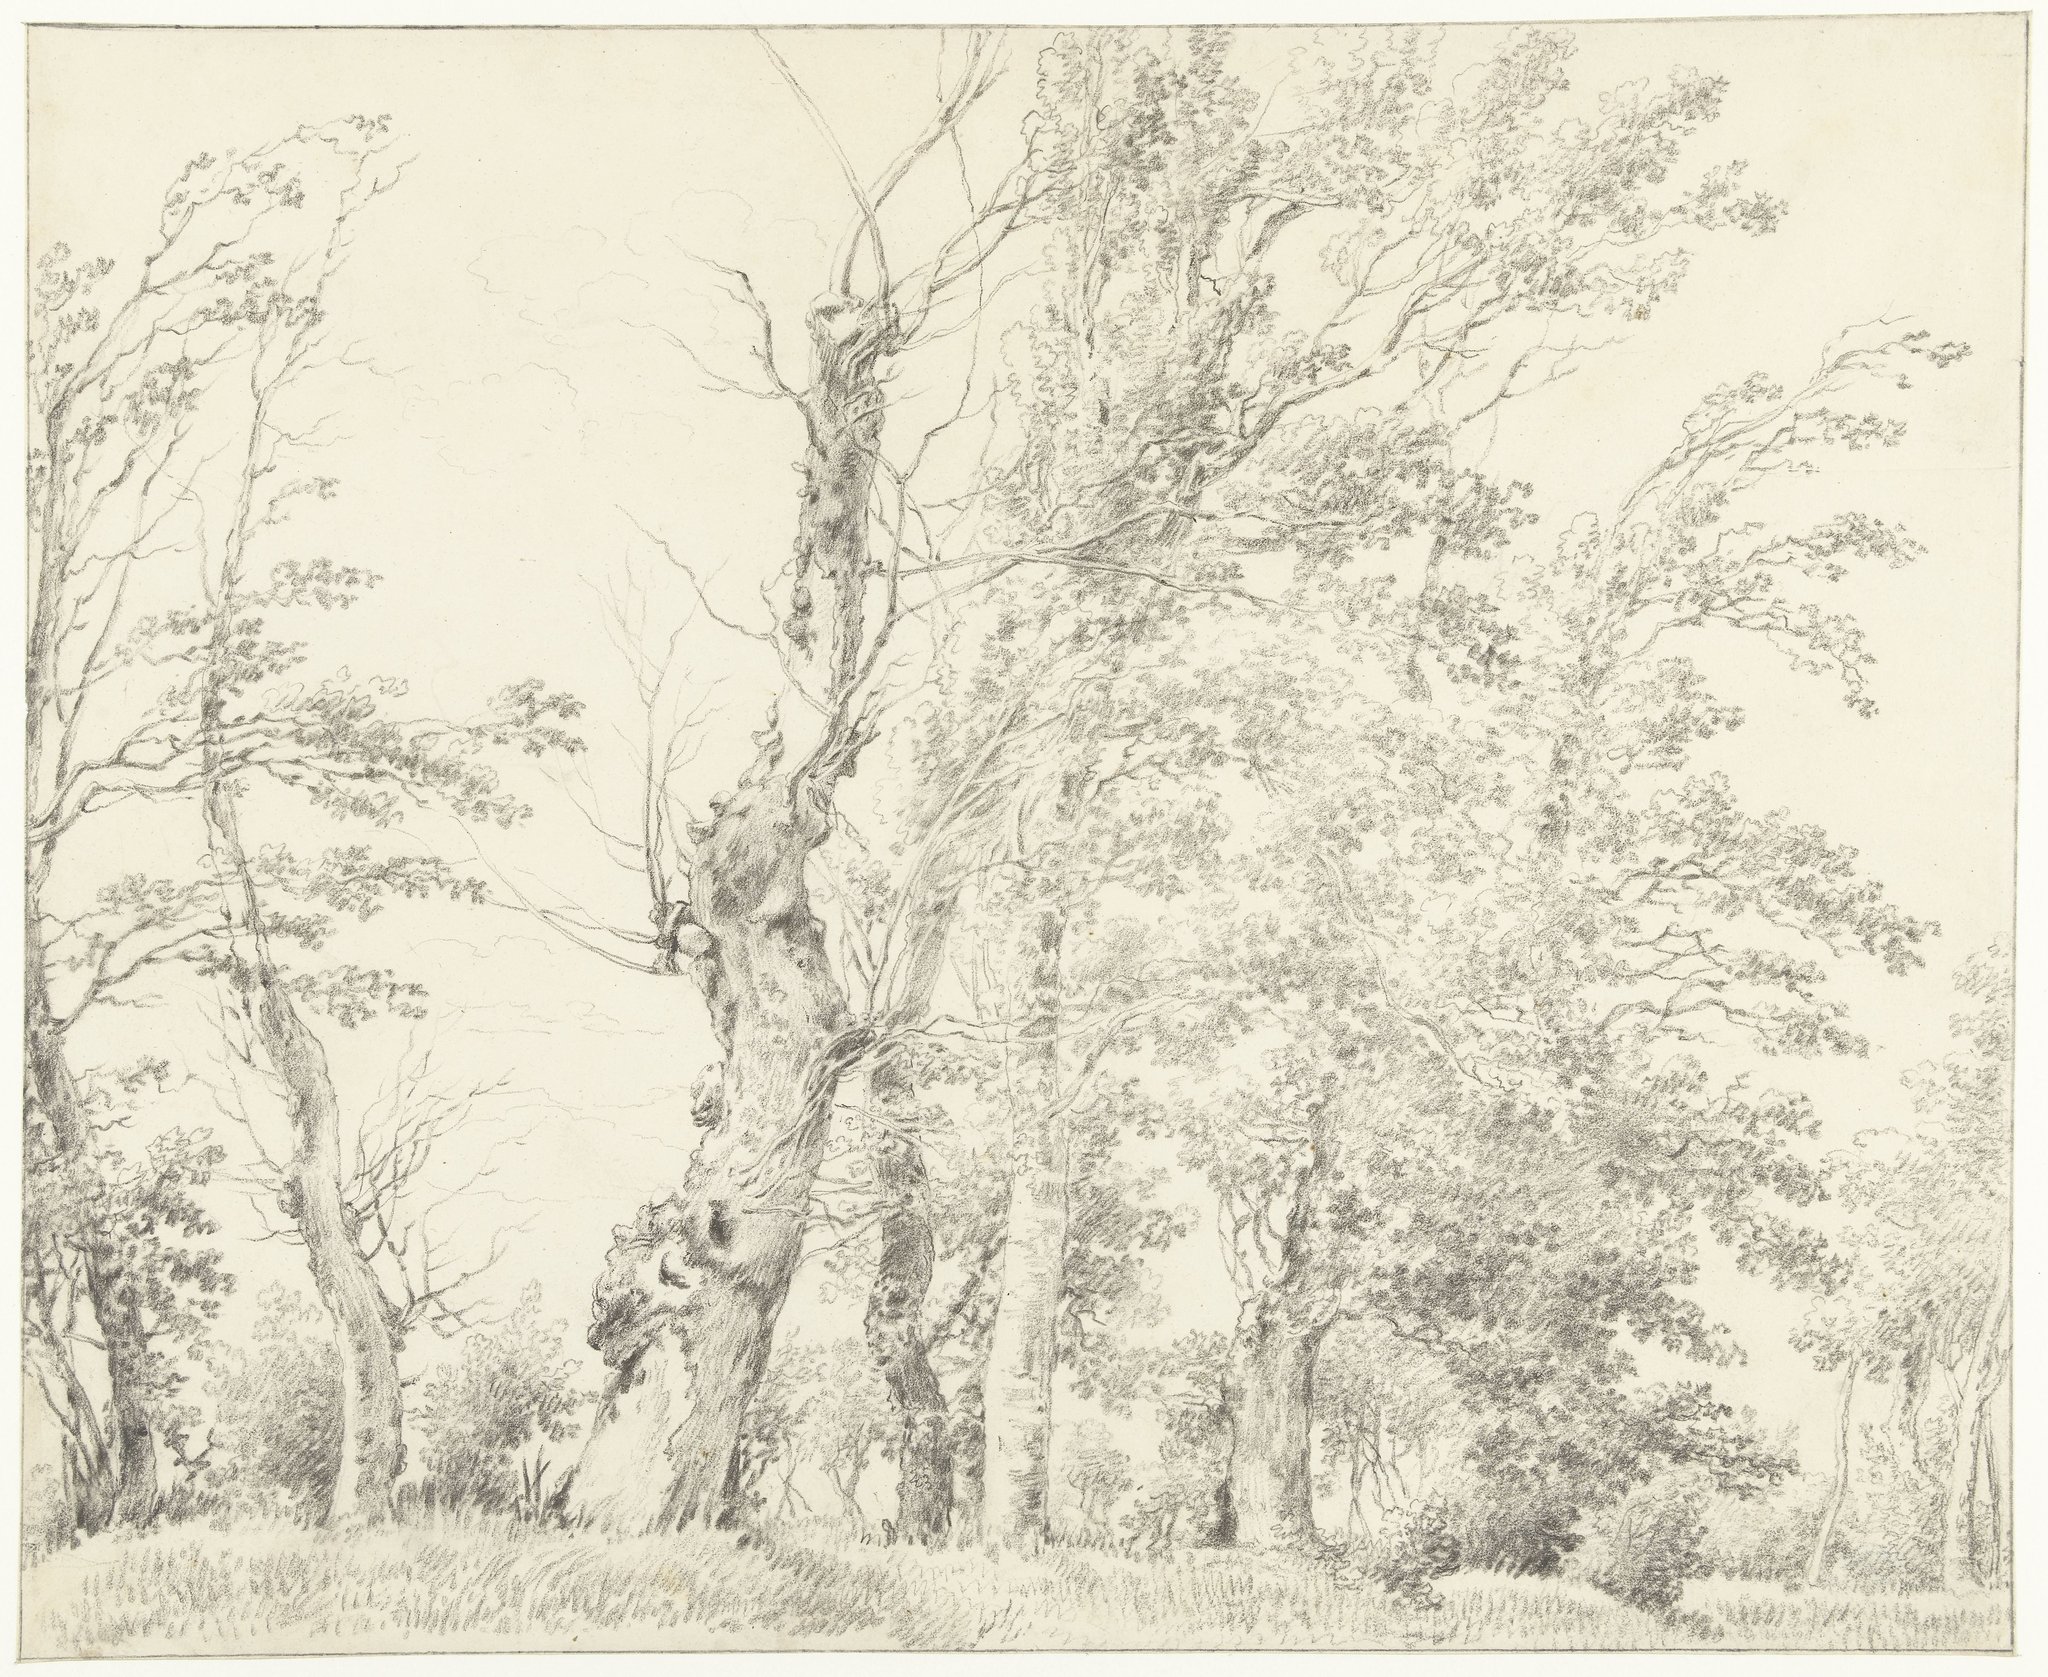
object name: drawing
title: Boomstudie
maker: steven goblé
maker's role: draughtsman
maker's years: 1749-1799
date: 1759-1799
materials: chalk, paper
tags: trees